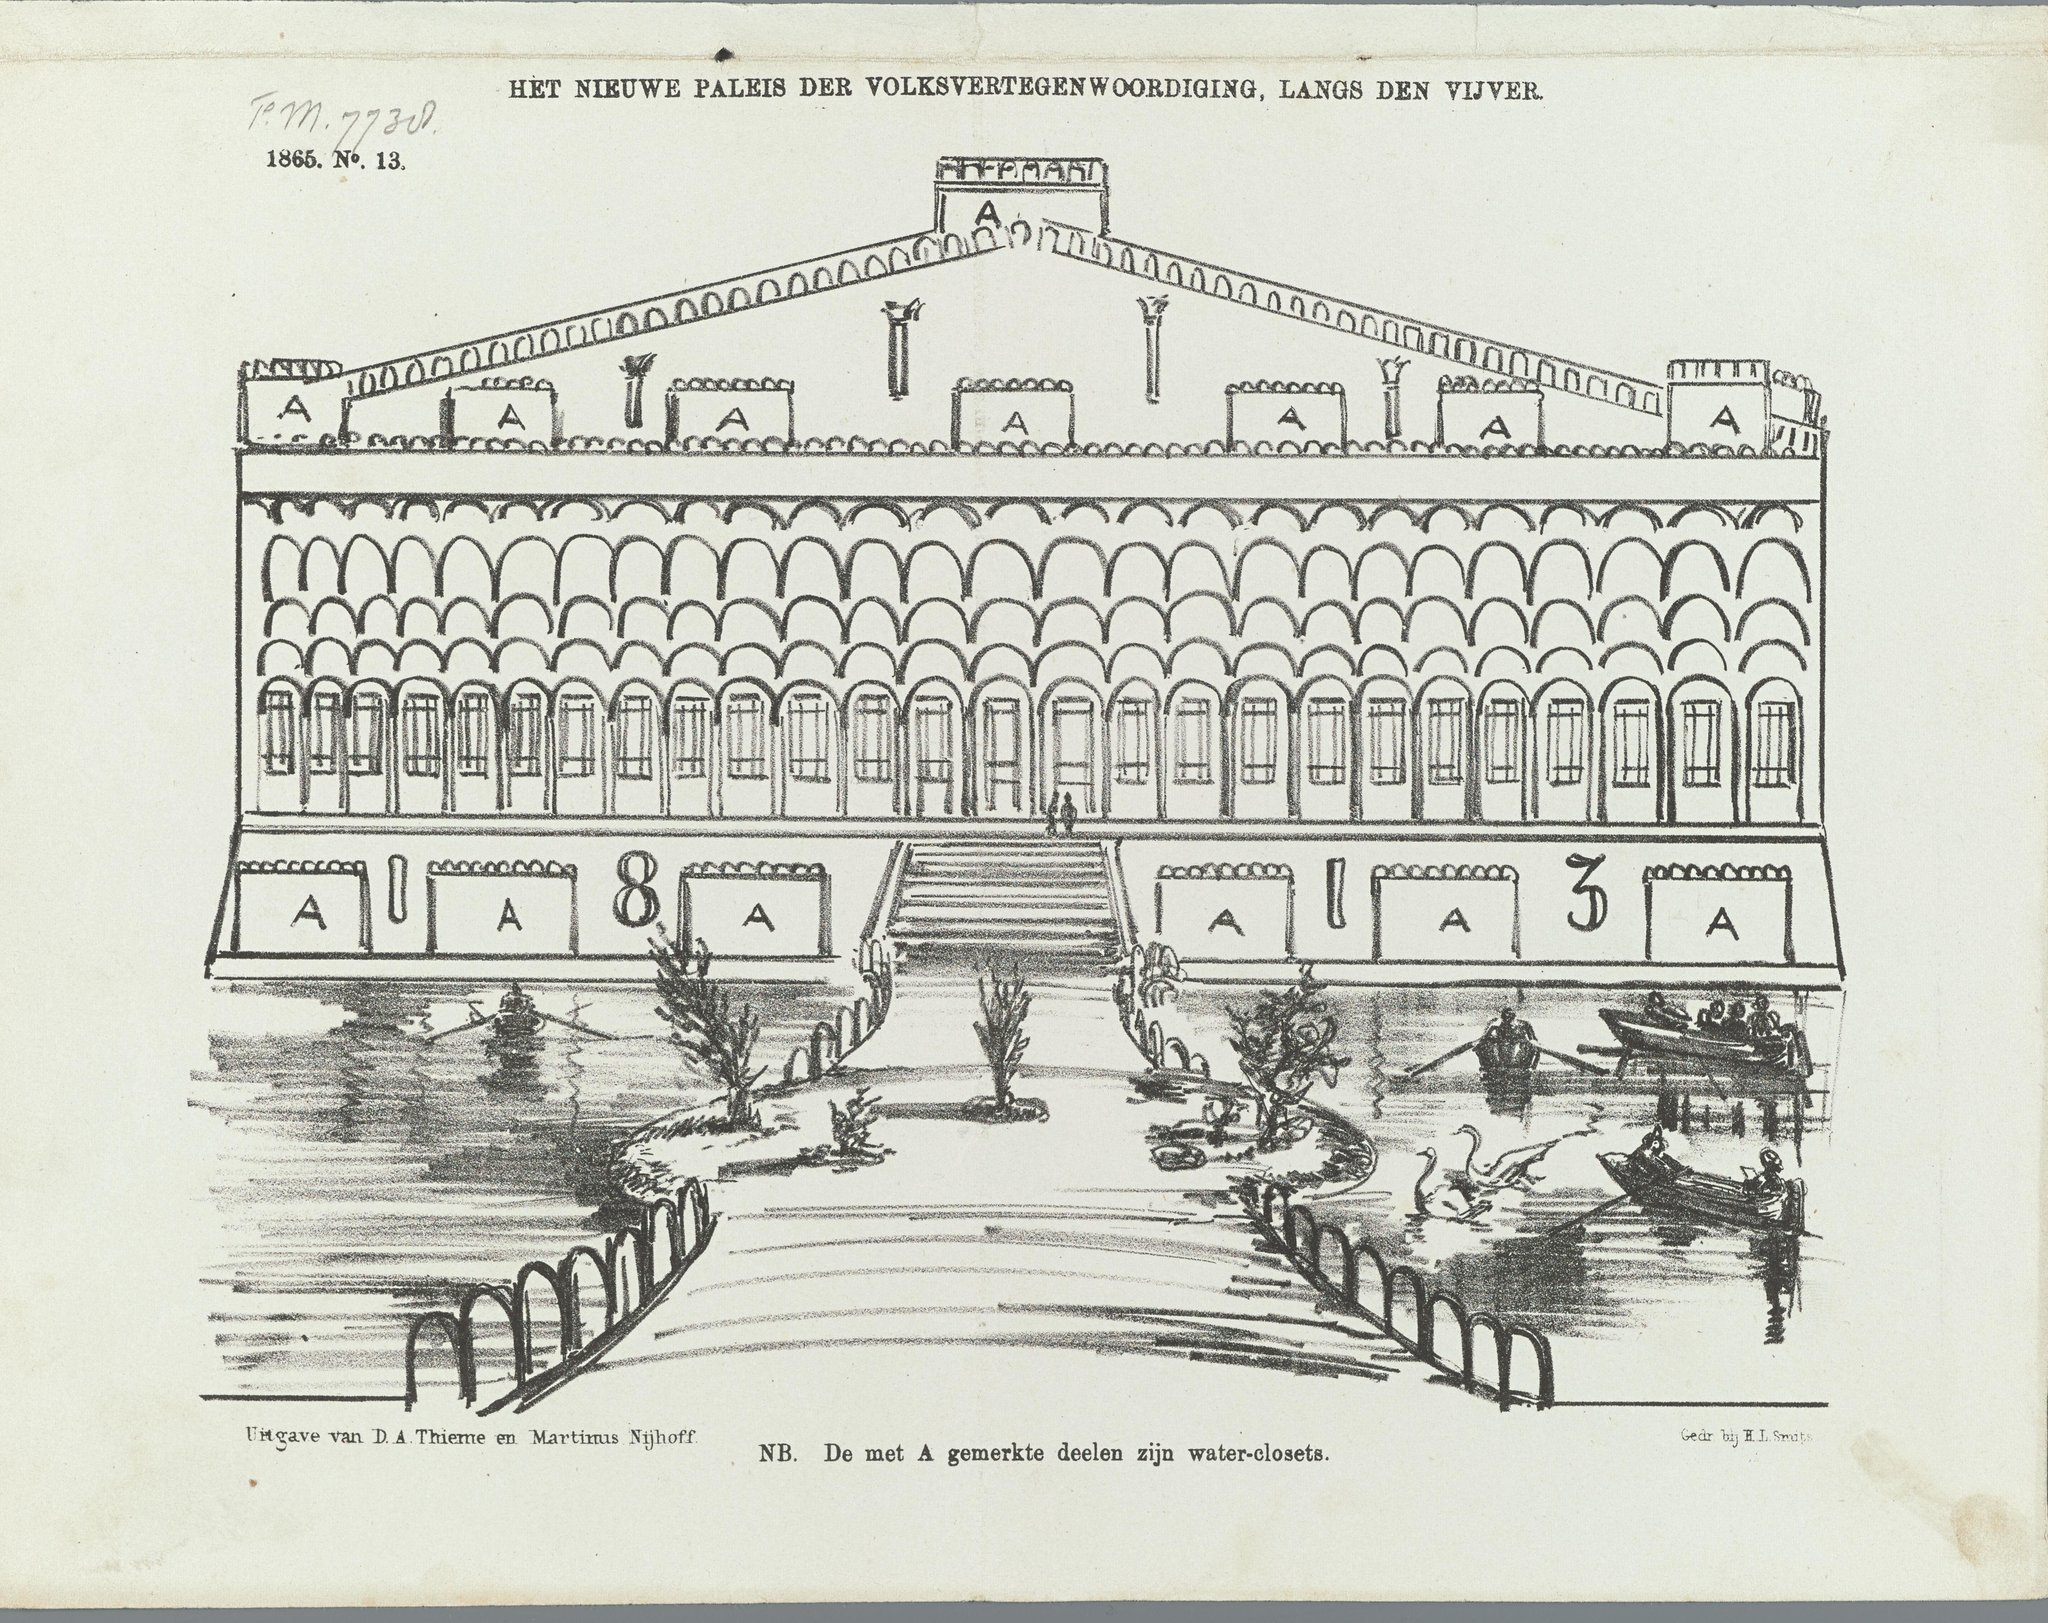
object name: cartoon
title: Spotprent op het ontwerp voor een nieuwe gebouw voor de Staten-Generaal, 1865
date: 1865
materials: paper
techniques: lithograph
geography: arnhem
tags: willem nicolaas rose, ideal and visionary architecture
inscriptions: collector's mark: Lugt 2228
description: Spotprent op een ontwerp voor een nieuwe gebouw voor de Staten-Generaal, in de stijl van de architect Rose. Plaat verschenen bij het weekblad De Nederlandsche Spectator, nr. 13, 1 april 1865.